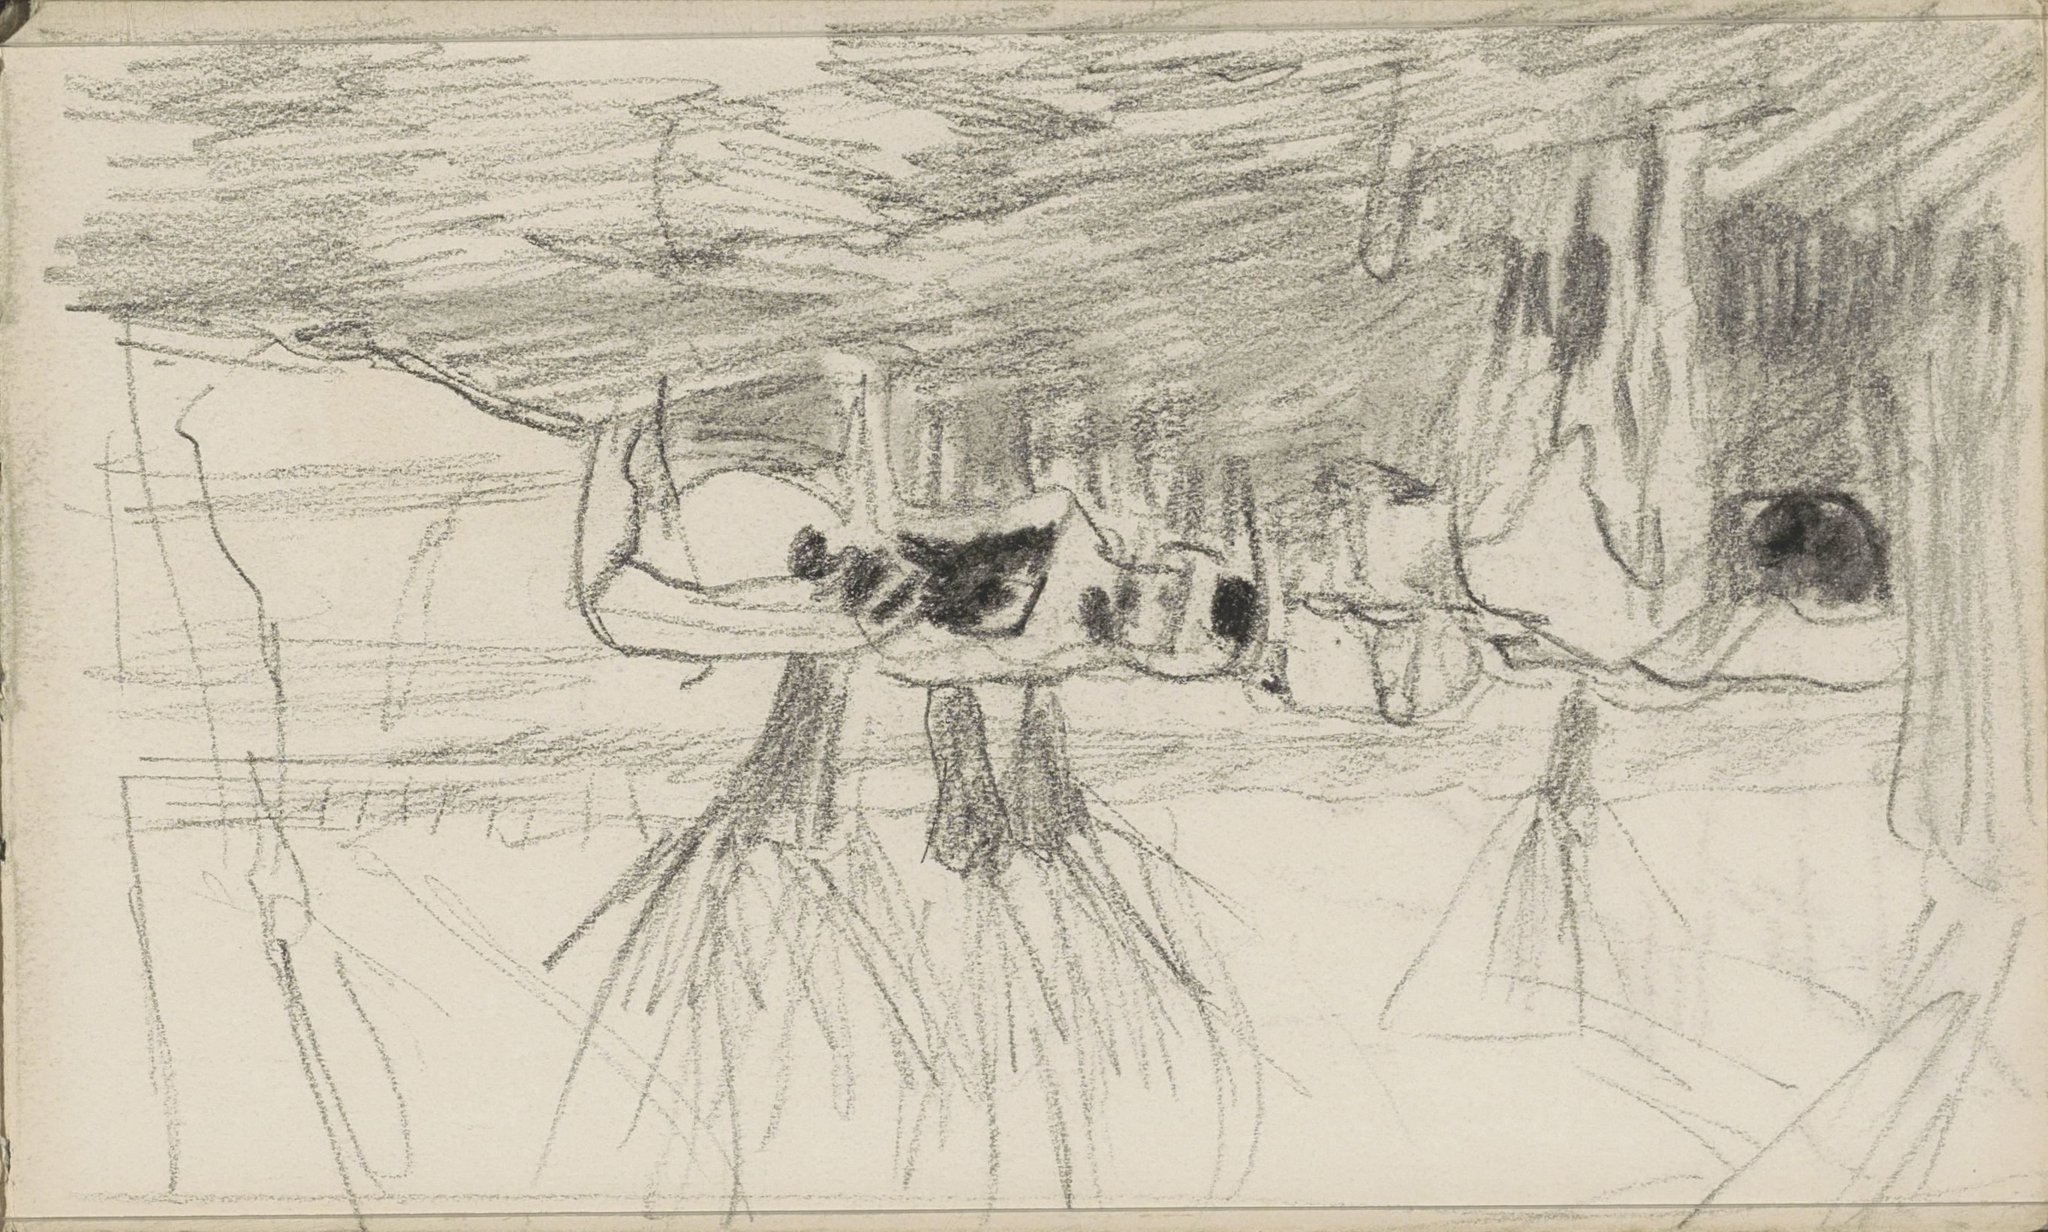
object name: sketchbook leaf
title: Koeien in een weiland bij enkele knotwilgen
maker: anton mauve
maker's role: draughtsman, painter, print maker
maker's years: 1838-1888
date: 1848-1888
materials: chalk, paper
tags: cow, trees: willow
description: Blad 15 recto uit een schetsboek met 33 bladen.